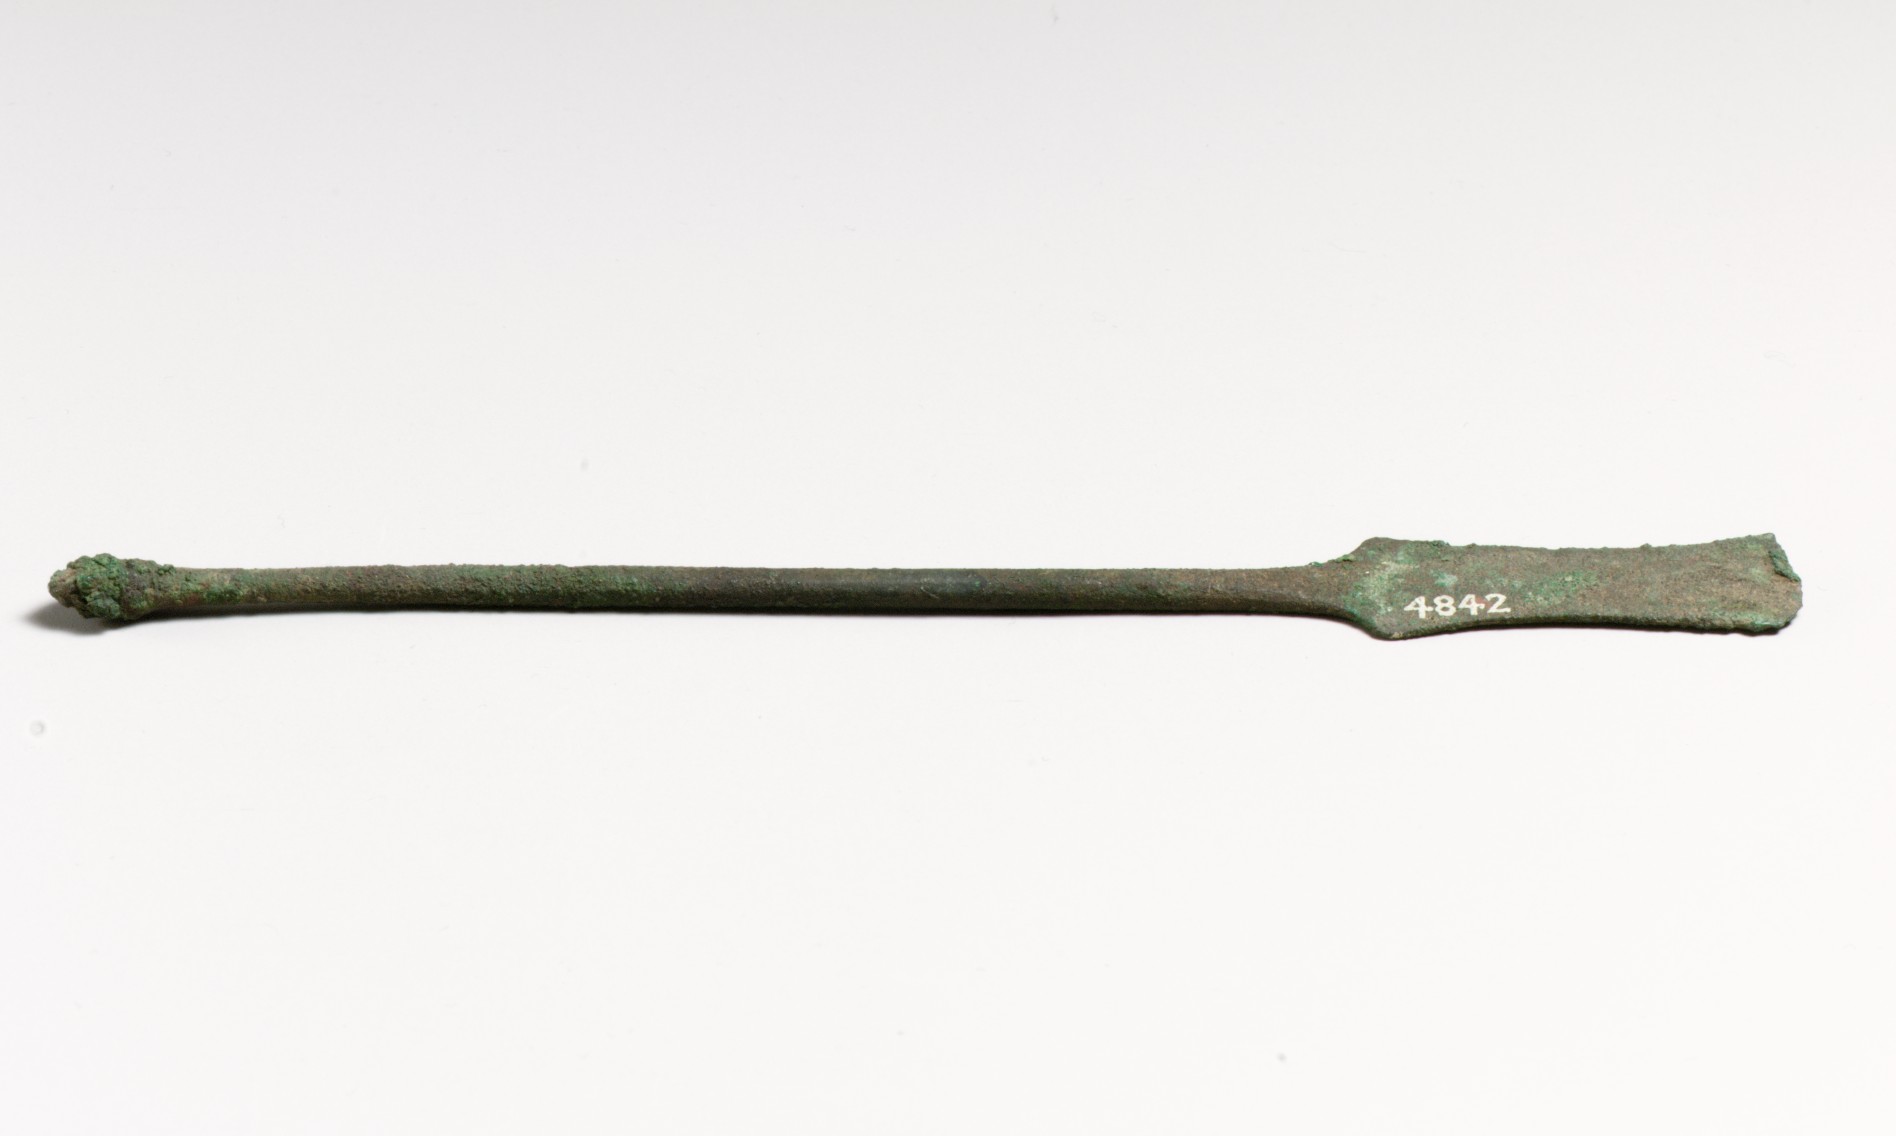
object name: spatula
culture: cypriot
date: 3900 BCE-100 CE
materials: bronze